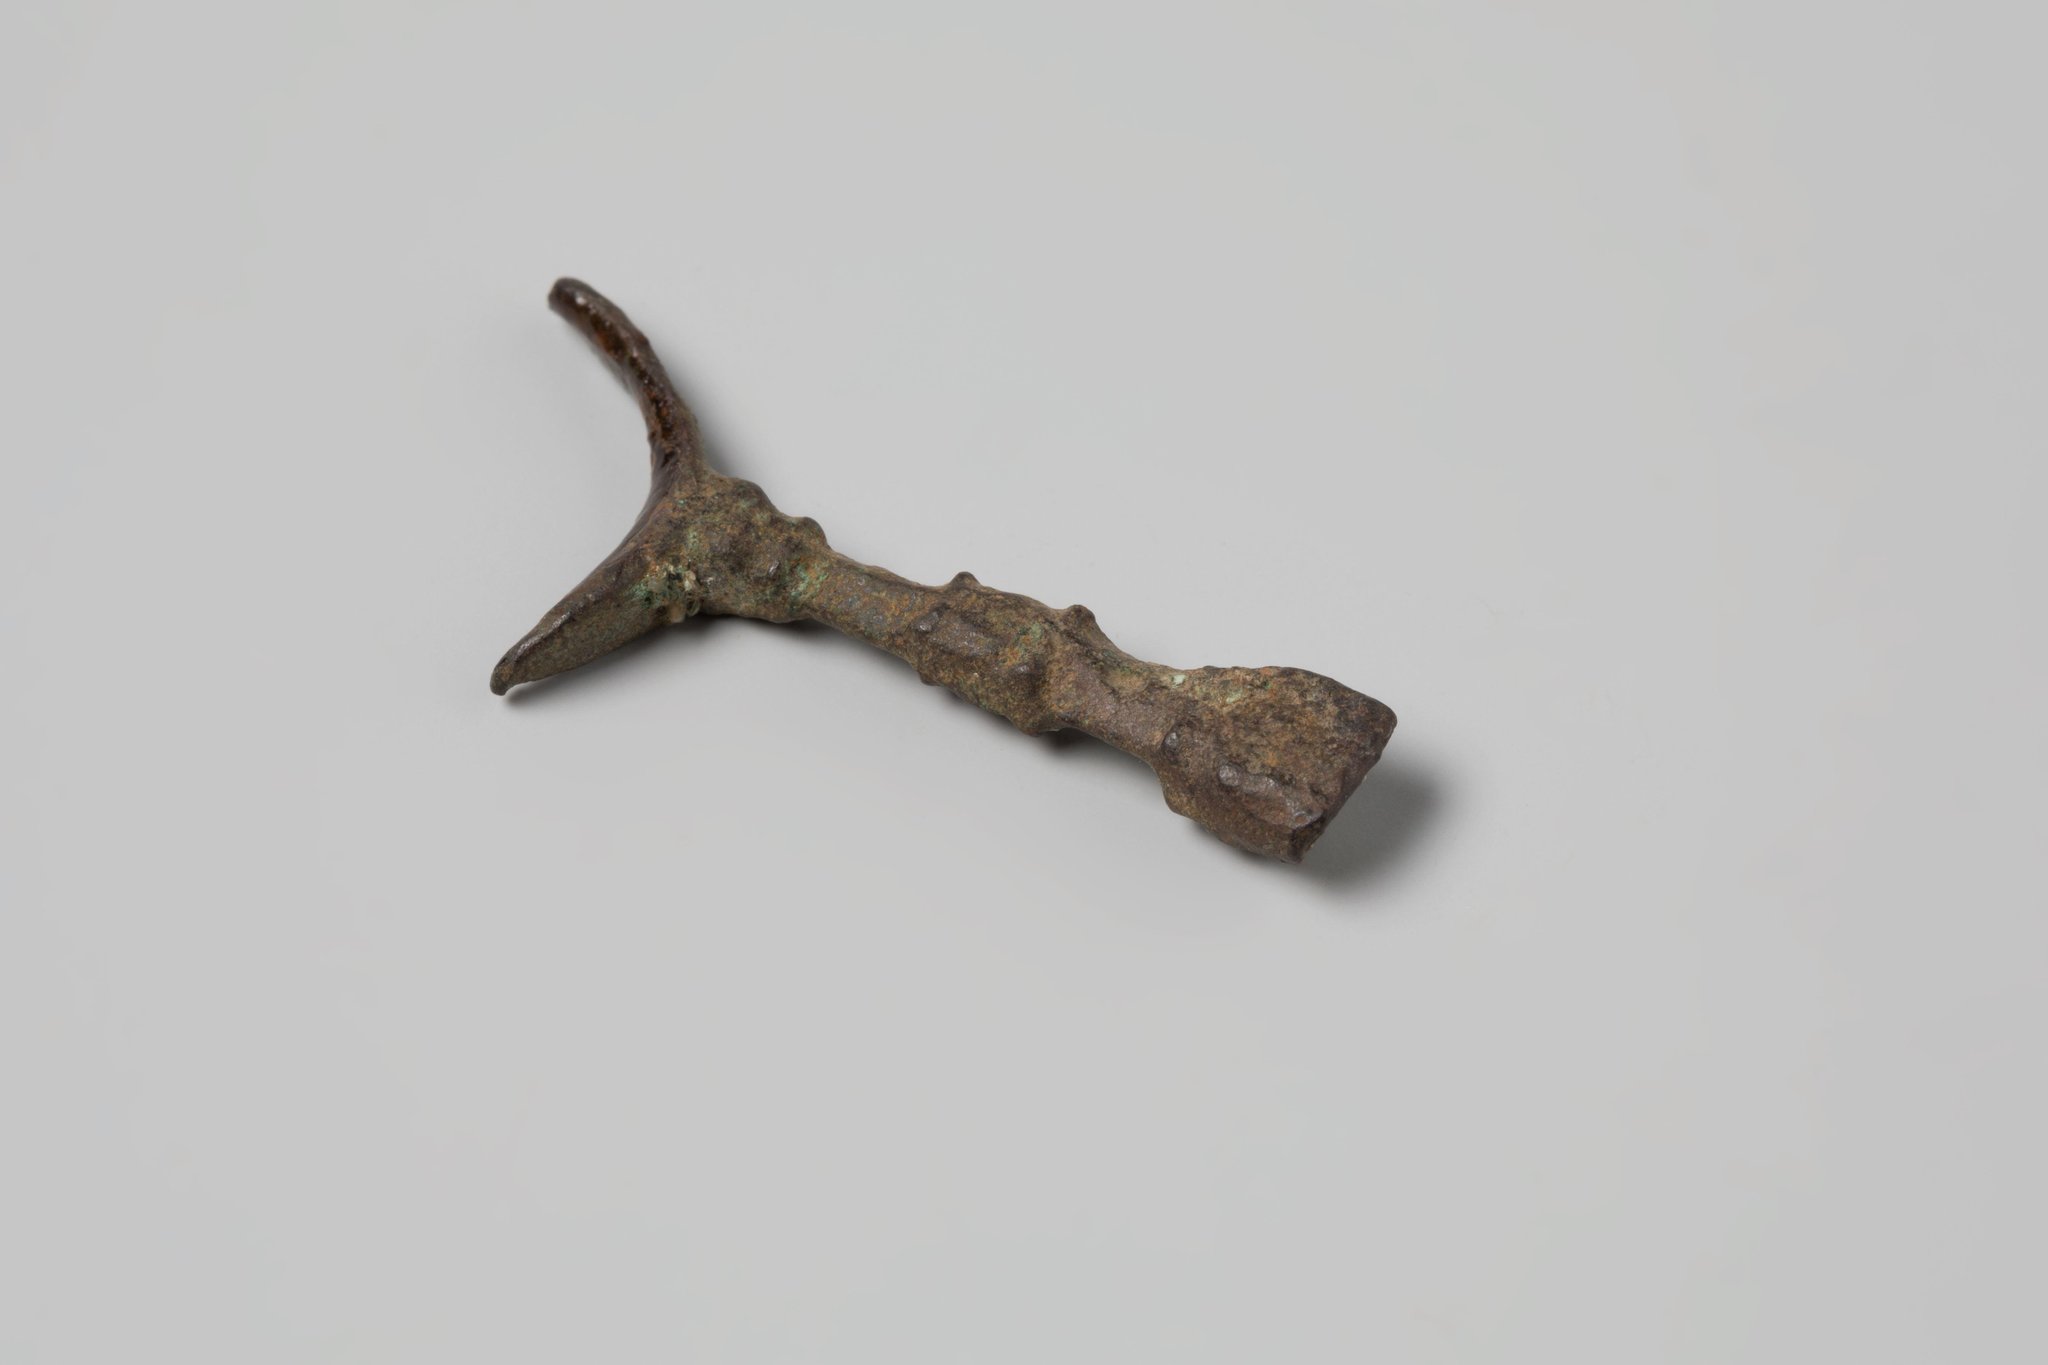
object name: pin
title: Fragment speld uit het wrak van de Oost-Indiëvaarder Hollandia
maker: Anonymous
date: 1700-1743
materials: copper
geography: netherlands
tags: verenigde oostindische compagnie, hollandia (schip), annet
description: Tools and instruments, sewing and sailmaking, pin; fragm of shaft with bow, id. NG 1980-27H3265, eroded.